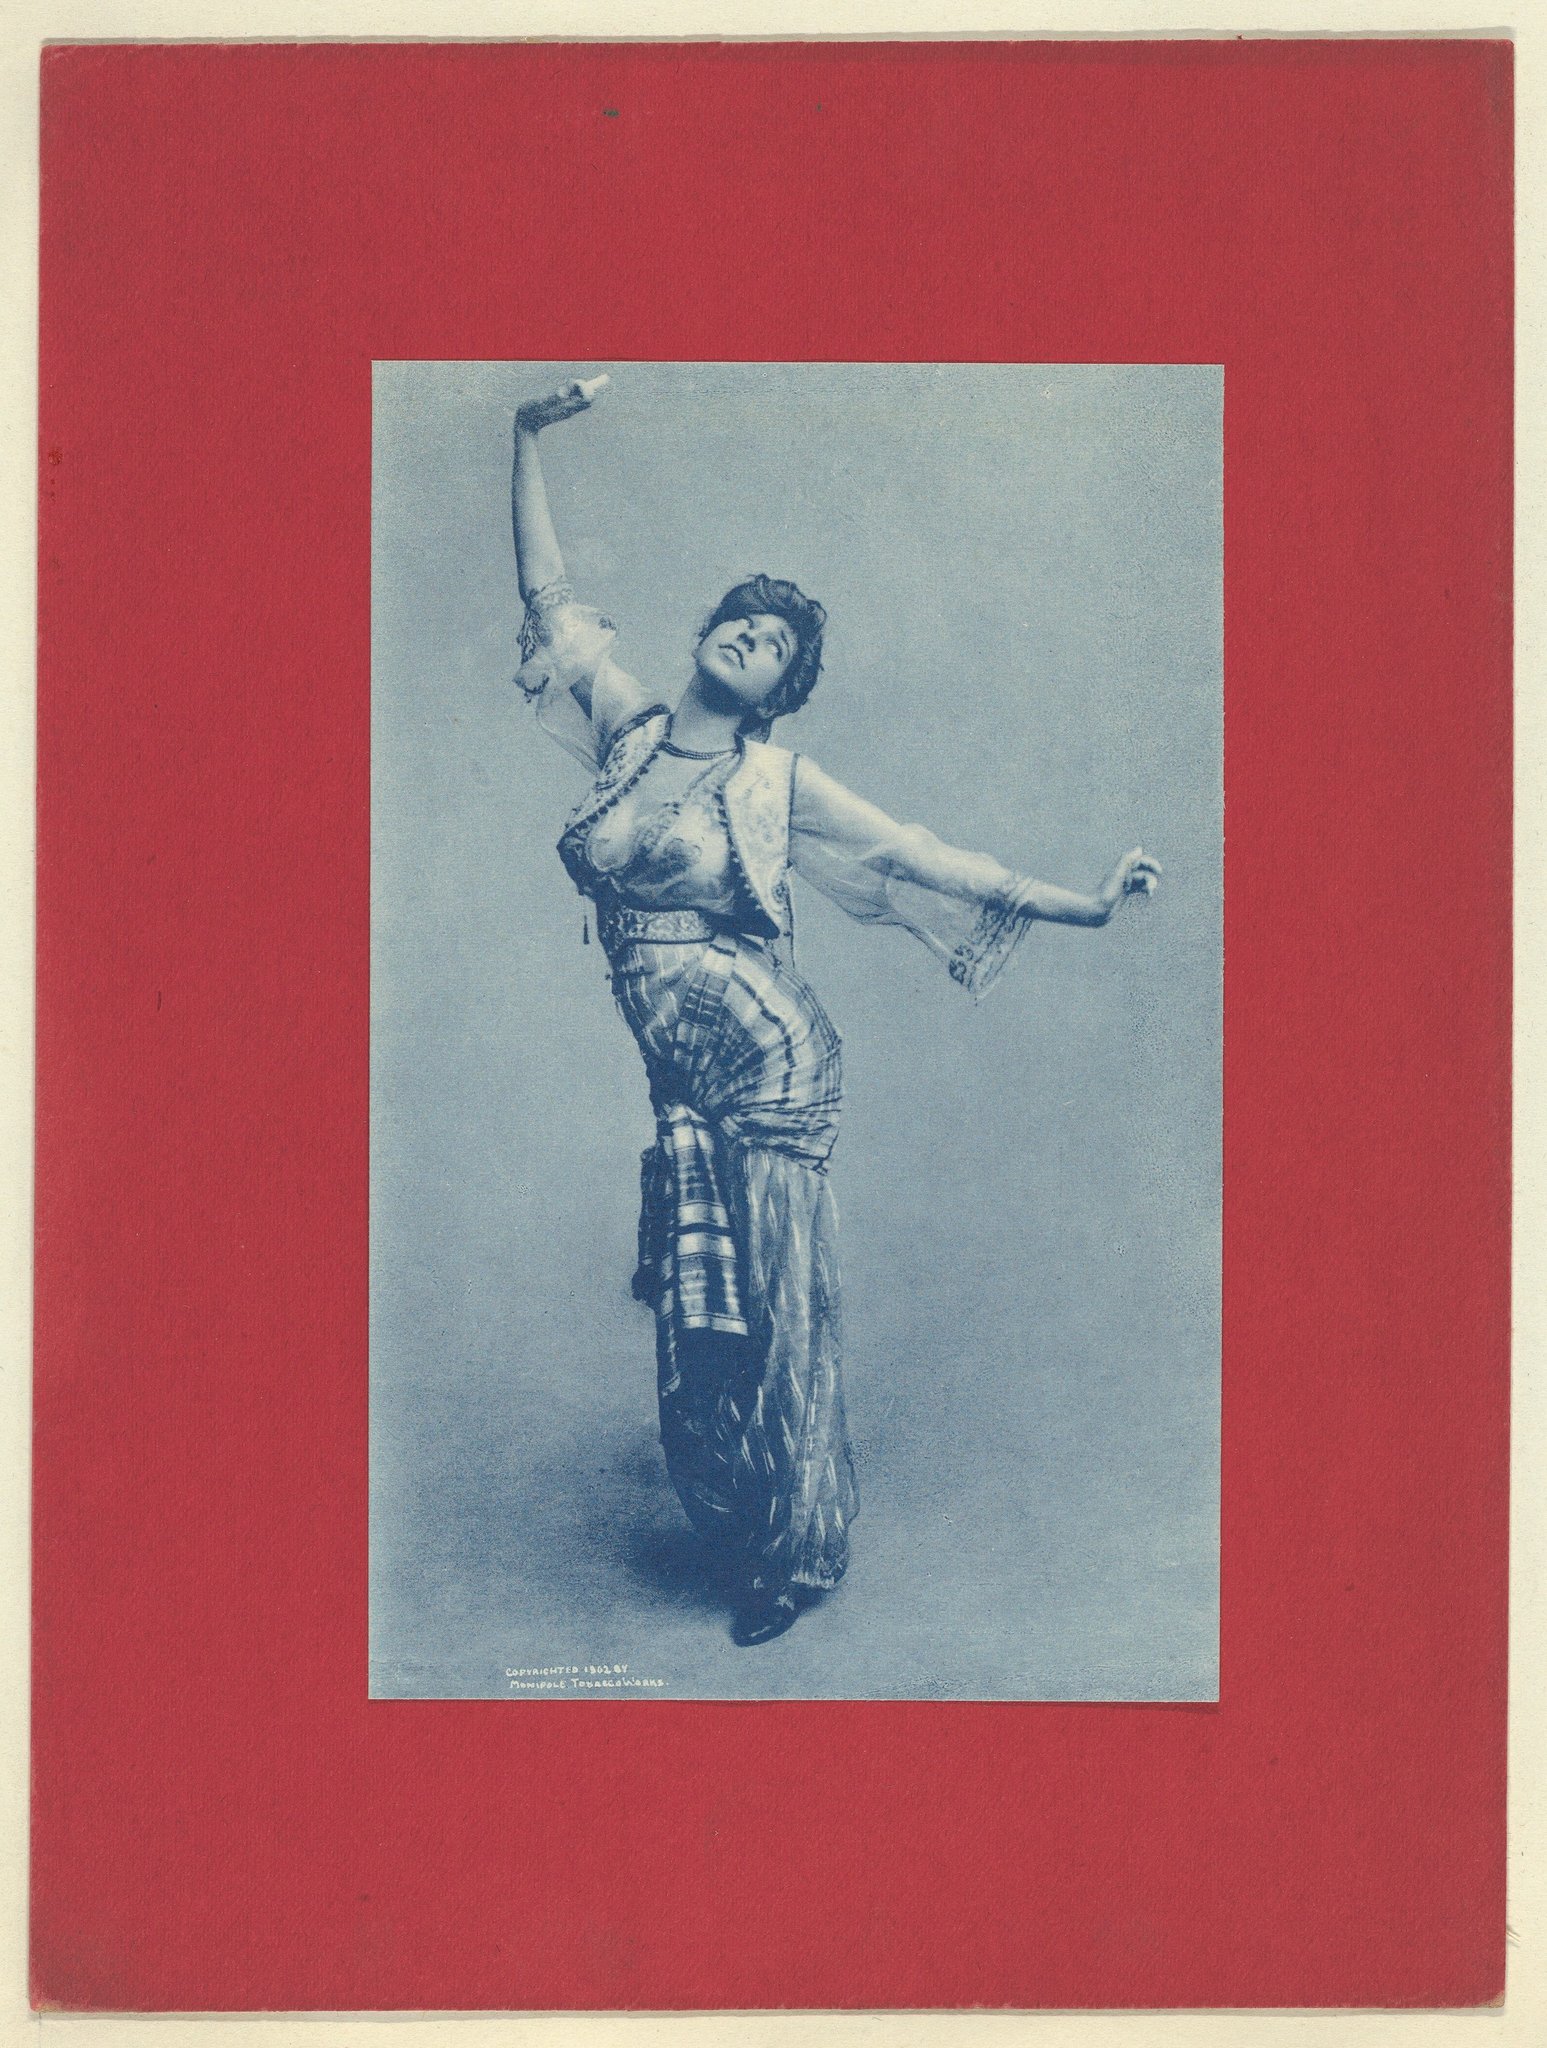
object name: print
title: Plate 3, from Little Egypt Actresses series (T2), issued by Monopole Tobacco Works to promote Khedive Egyptian Cigarettes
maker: monopole tobacco works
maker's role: publisher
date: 1902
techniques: photolithograph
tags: portraits,women,actresses